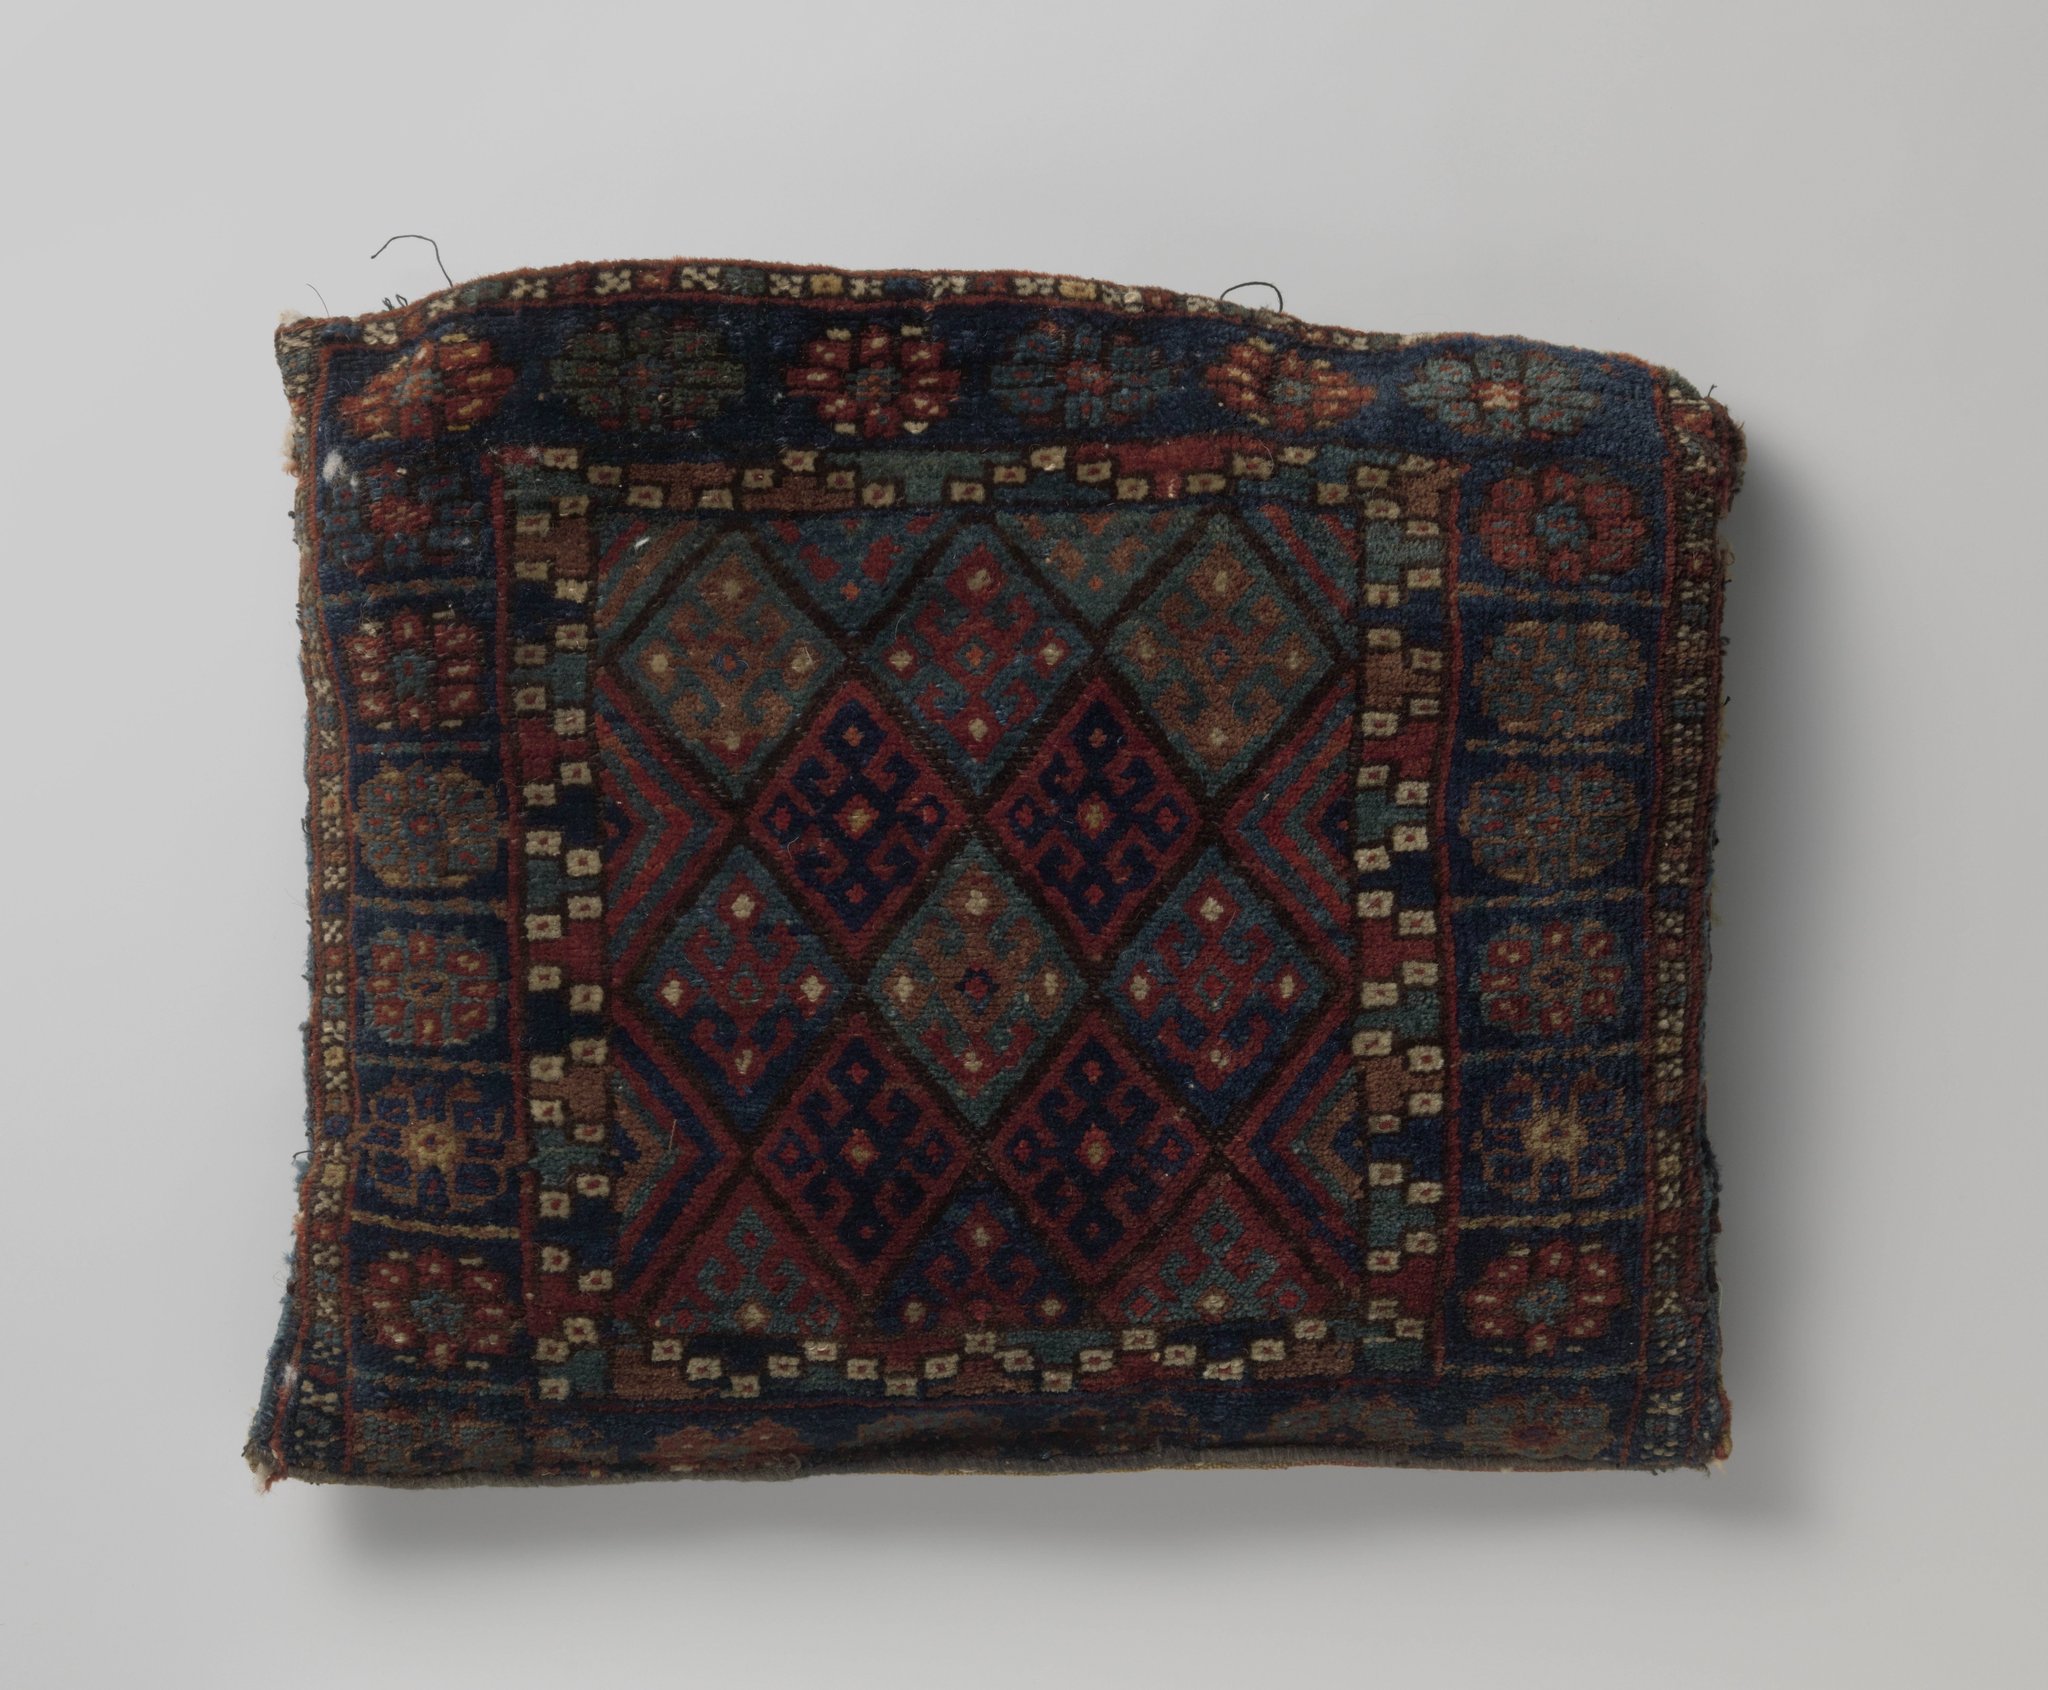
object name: voorblad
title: Voorblad zadeltas versierd met rastermotief; drievoudige rand met rozetbloemen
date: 1800-1900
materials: wool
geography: kurdistan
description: Voorblad van een zadeltas, Jaffi-Kurdistan-Mosul, waarvan het middenveld door een raster verdeeld is in ruiten. Drievoudige rand waarvan de middelste versierd is met rechthoeken waarbinnen rozetbloemen. Onderaan een geborduurde baard.